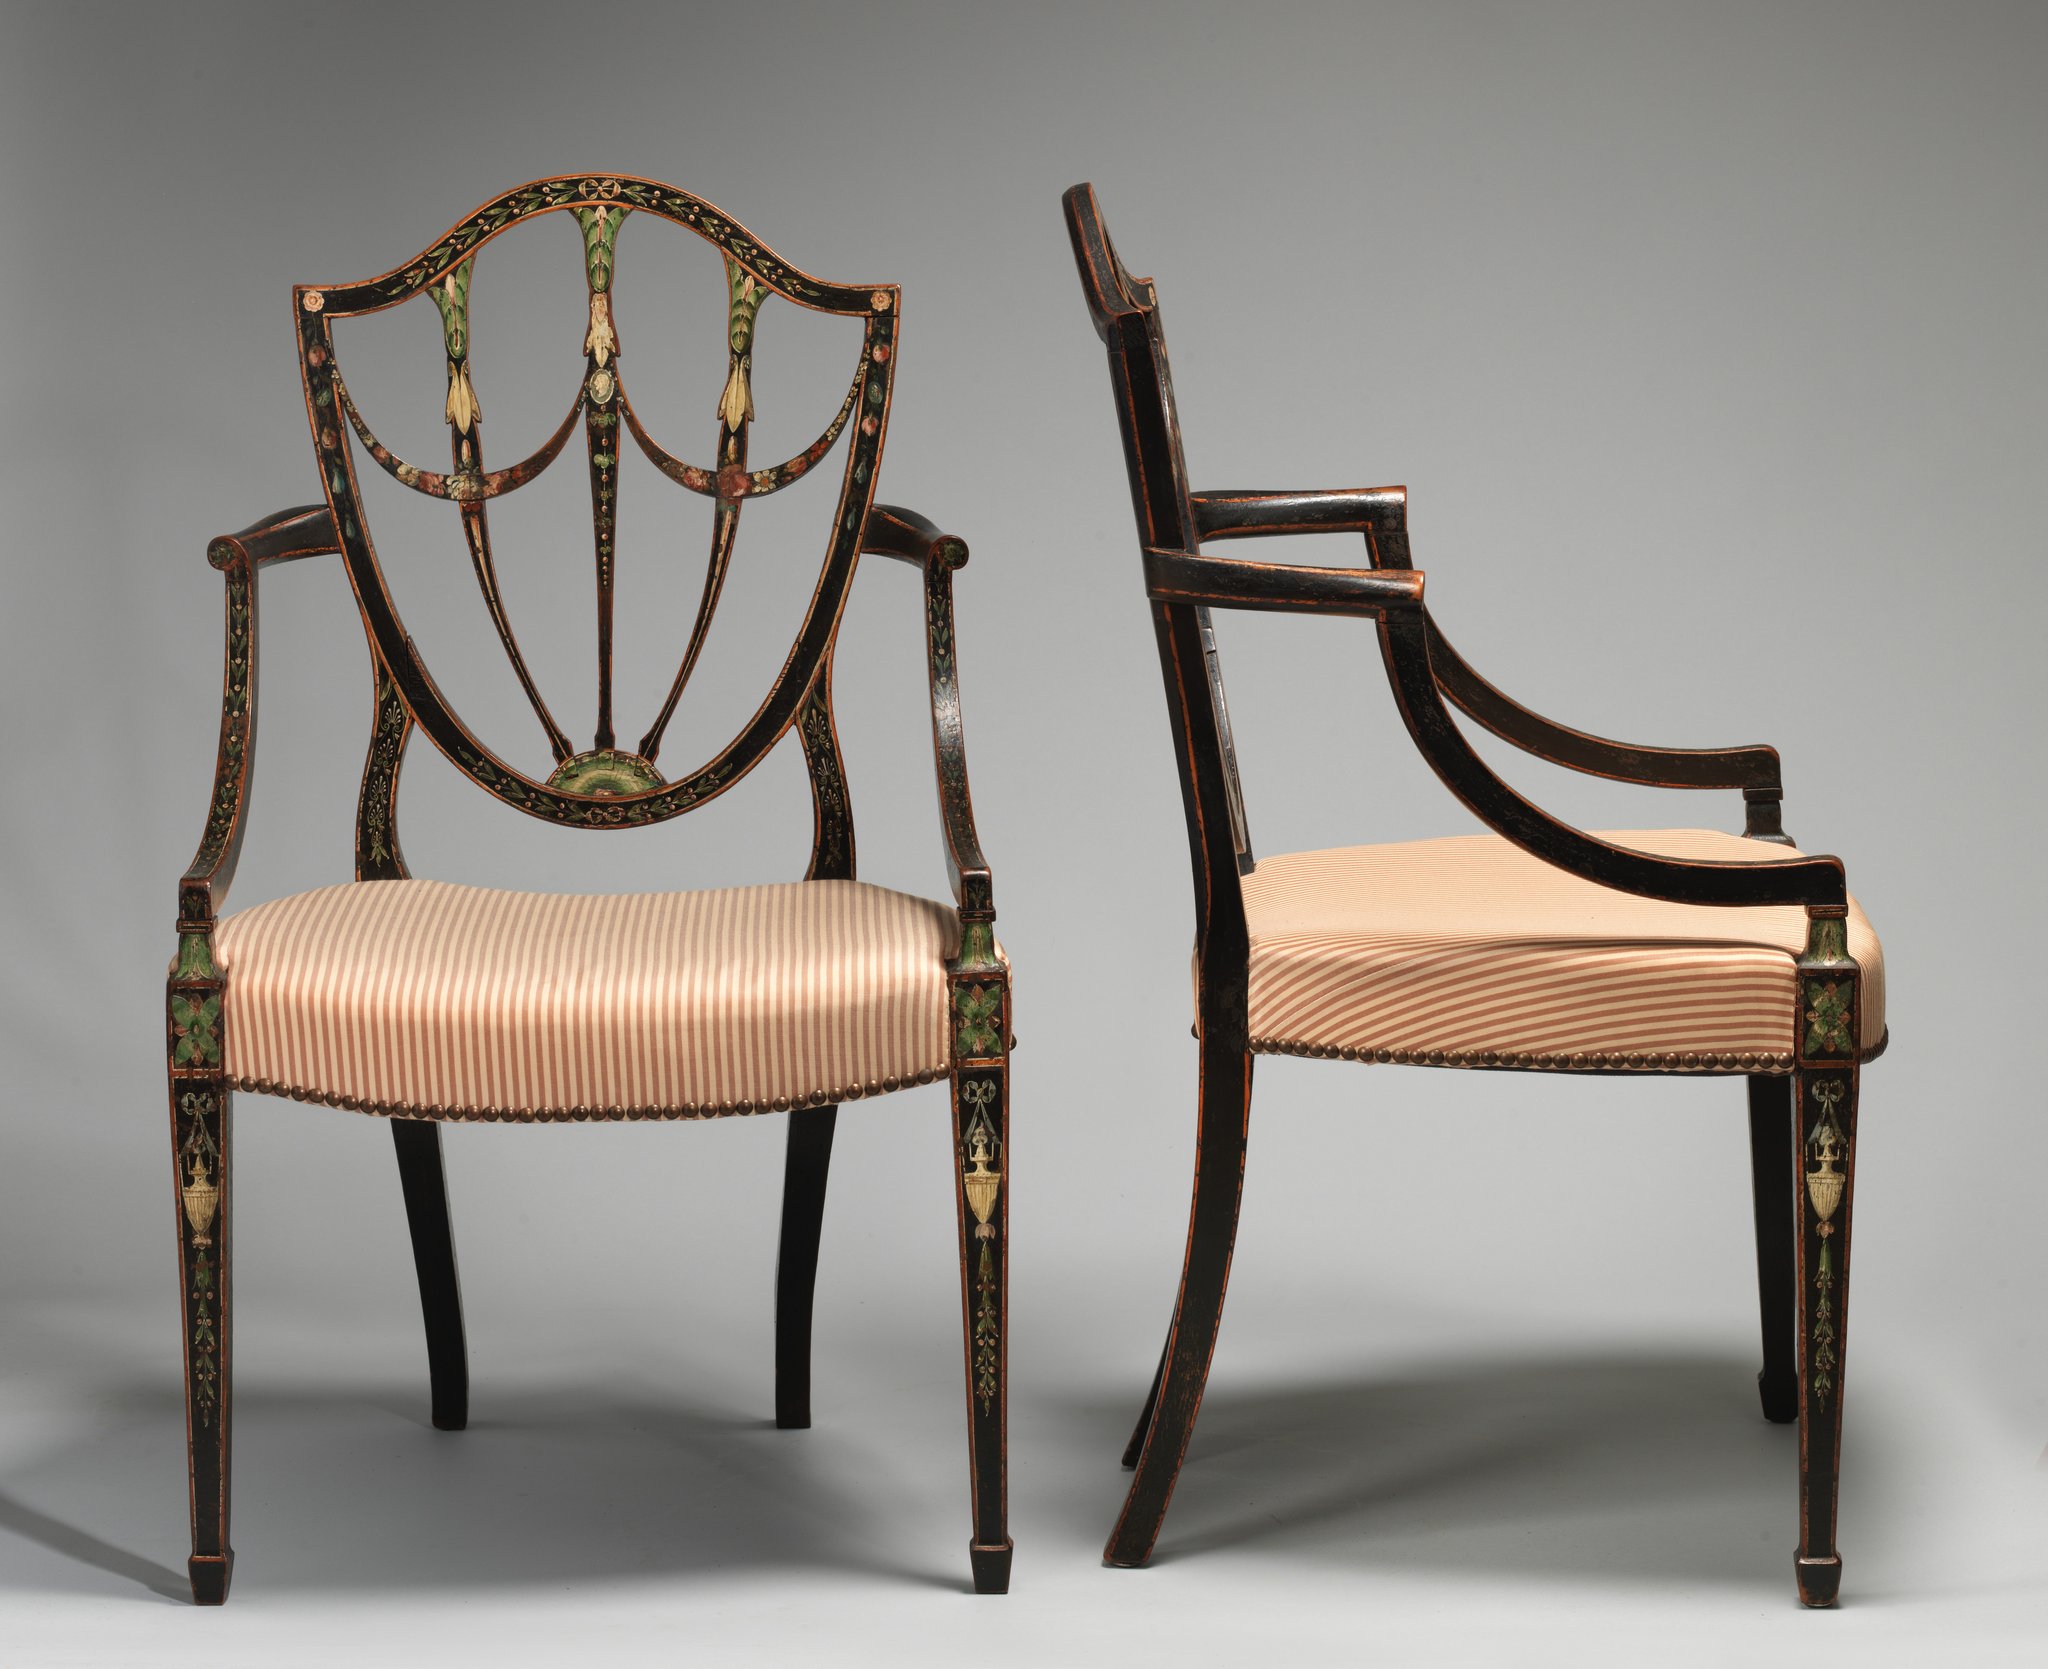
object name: armchair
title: Pair of armchairs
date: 1767-1800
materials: wood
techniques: painting